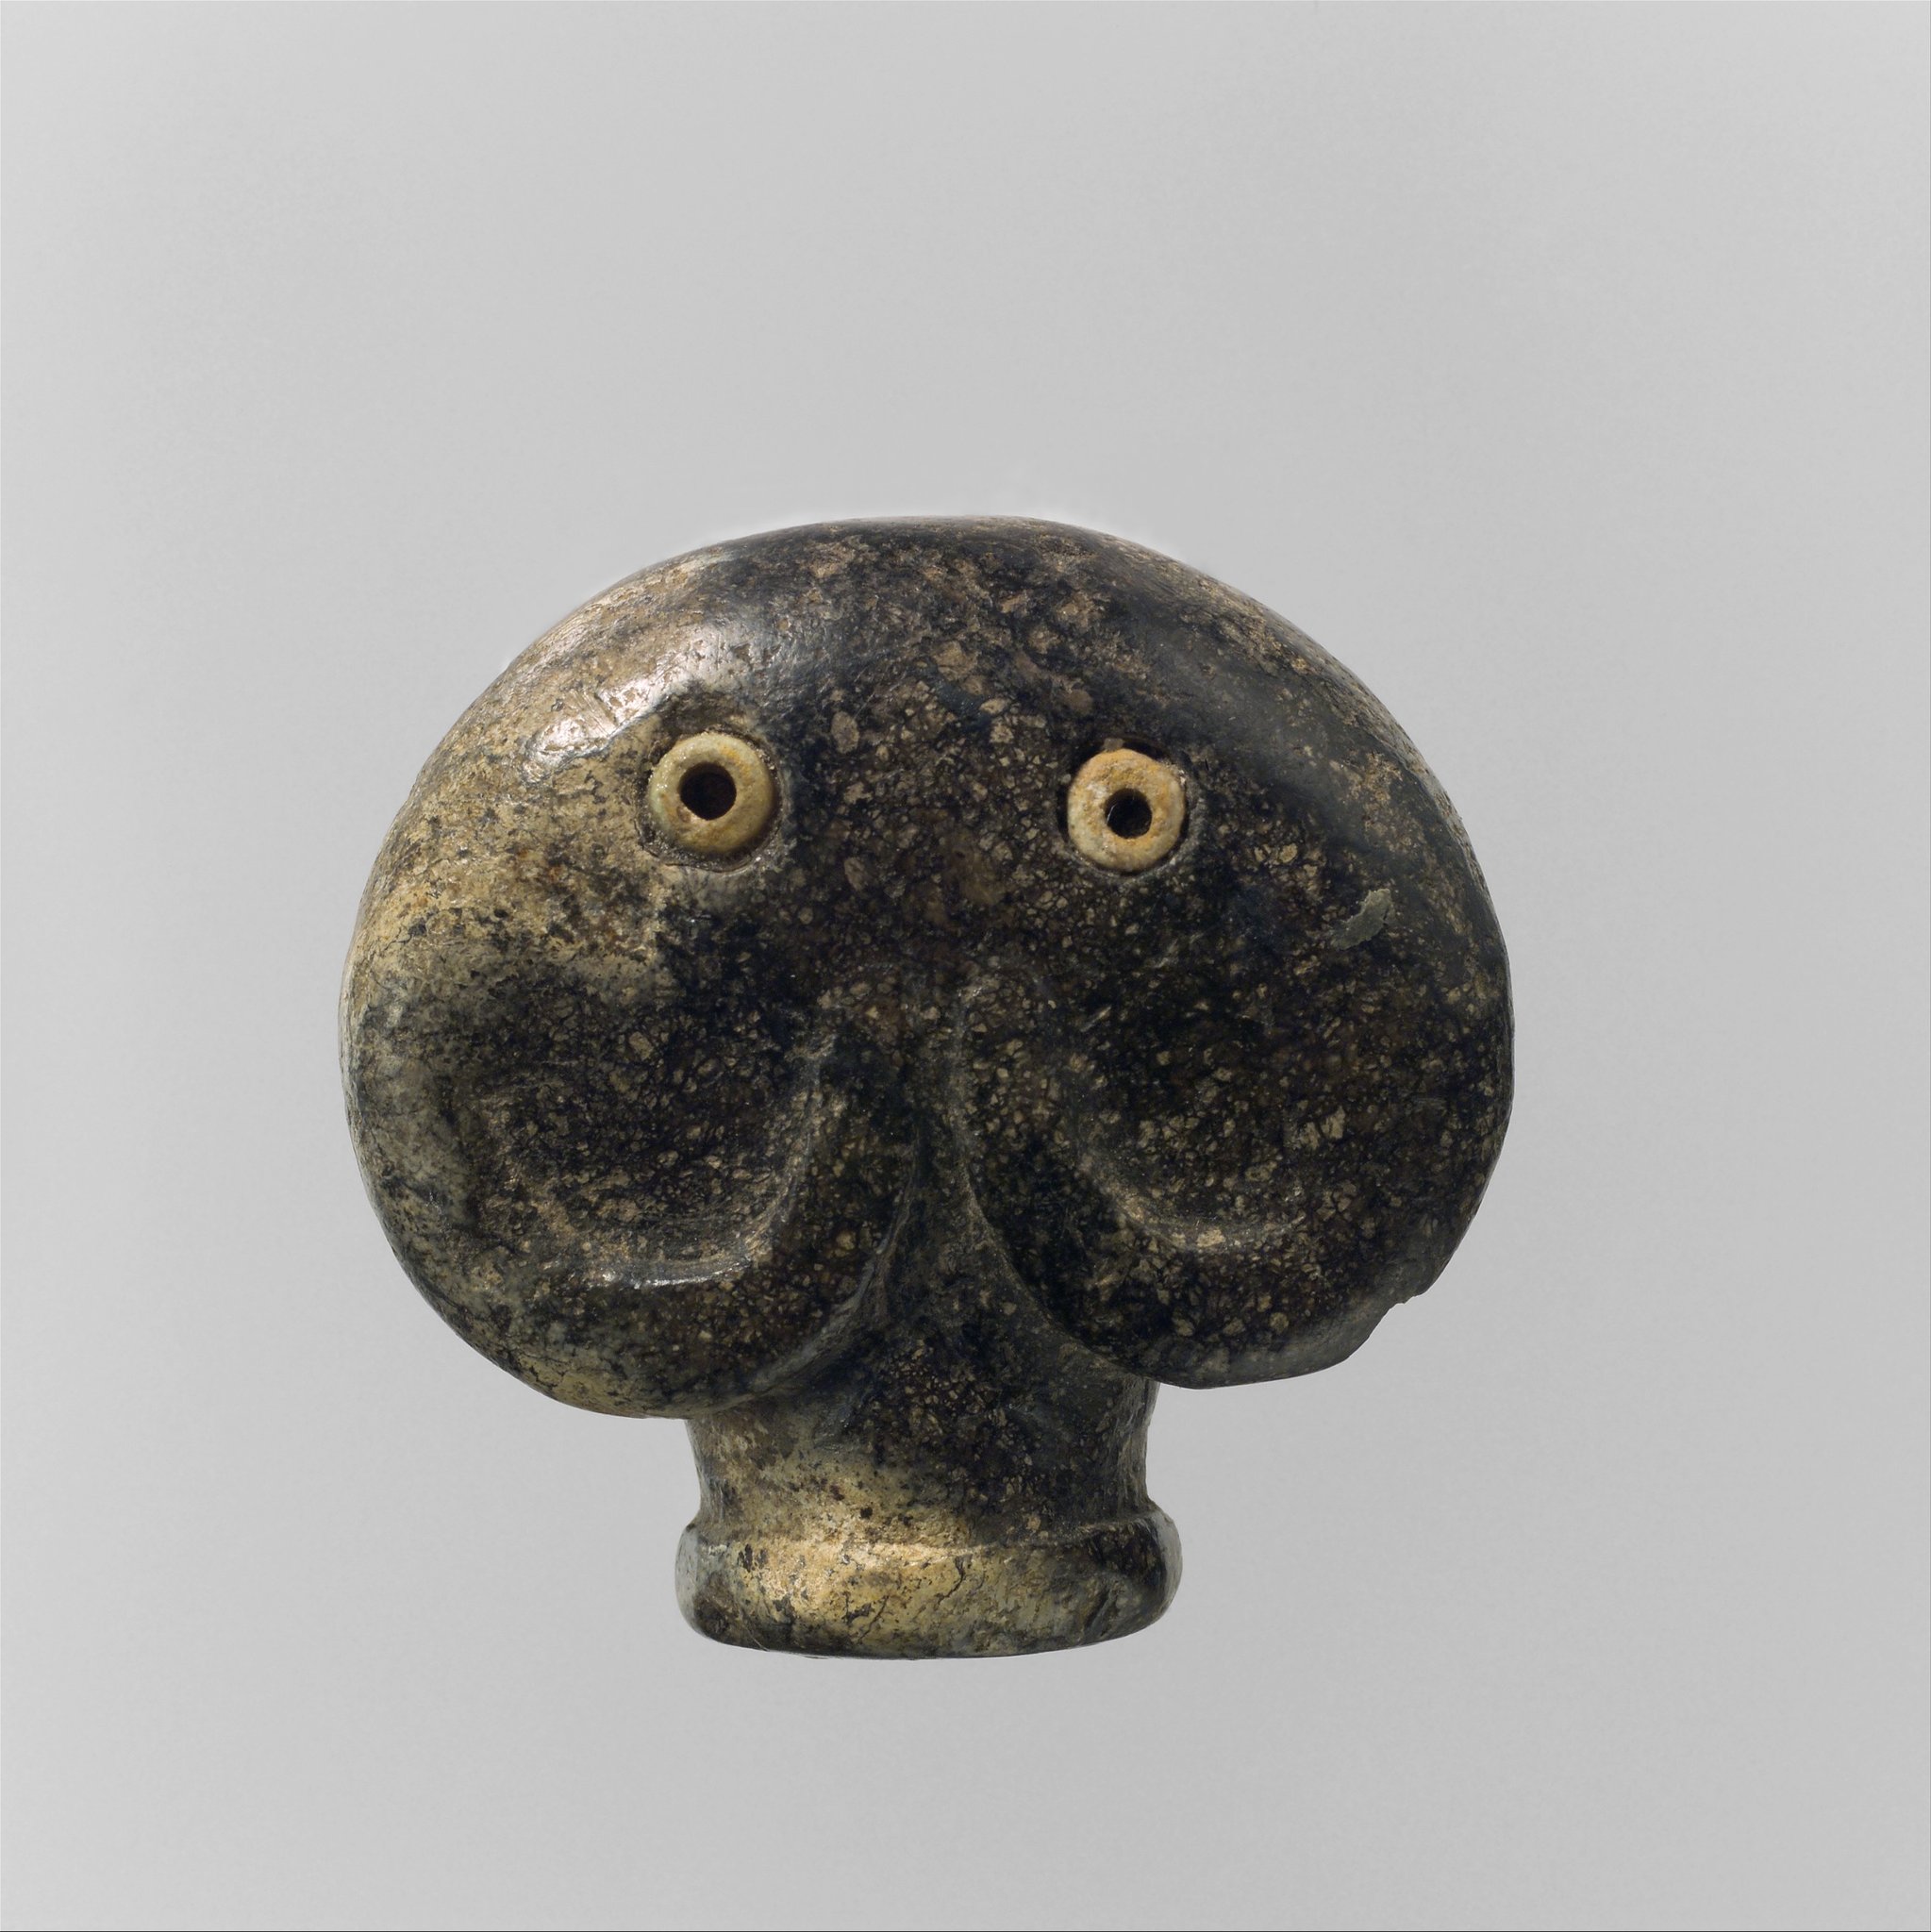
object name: amulet, elephant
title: Amulet in the form of a head of an elephant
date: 3500-3300 BCE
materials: bone, stone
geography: egypt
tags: elephants